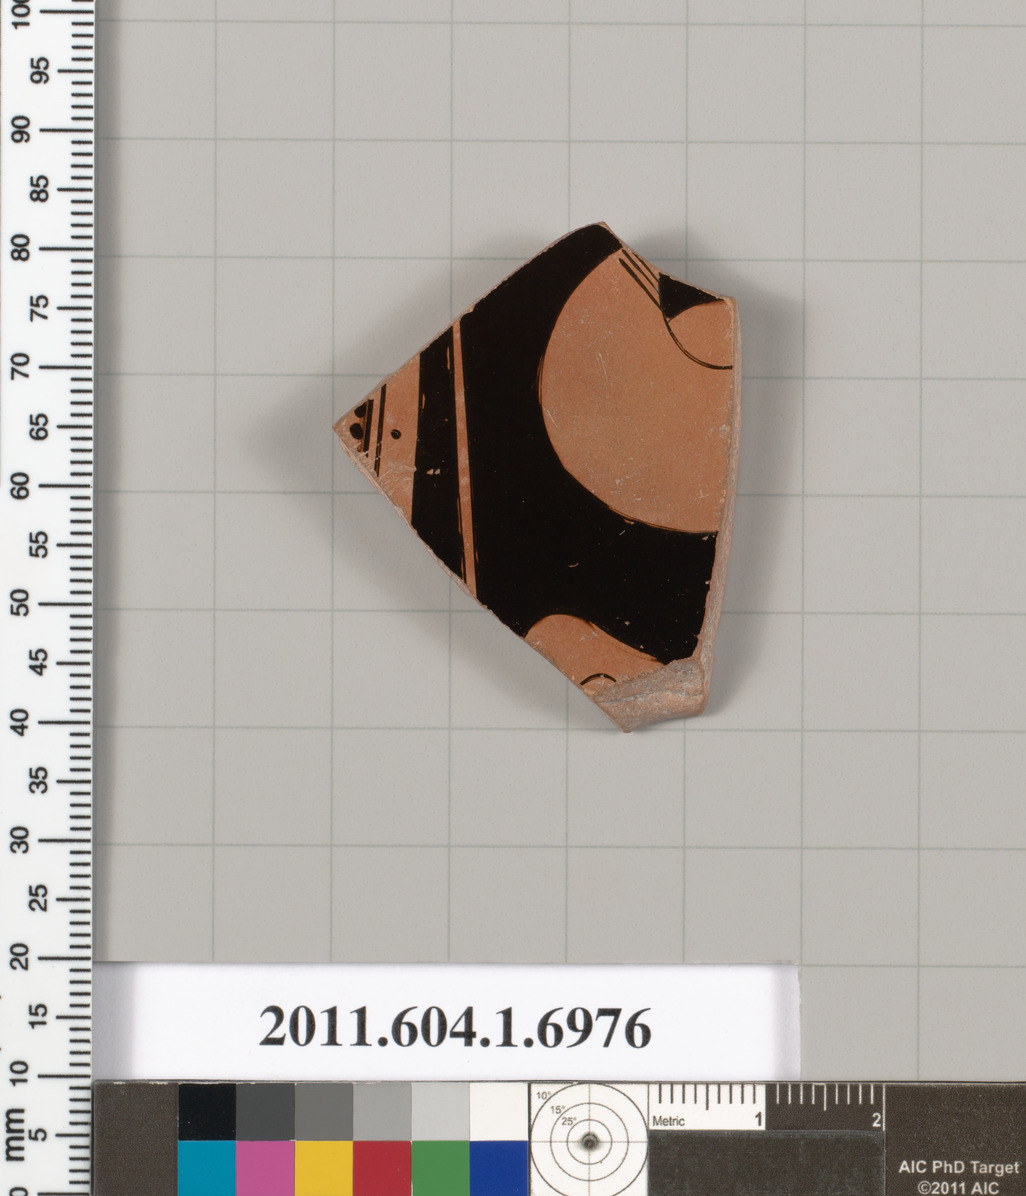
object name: kylix fragment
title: Terracotta fragment of a kylix (drinking cup)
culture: greek, attic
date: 490-470 BCE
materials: terracotta